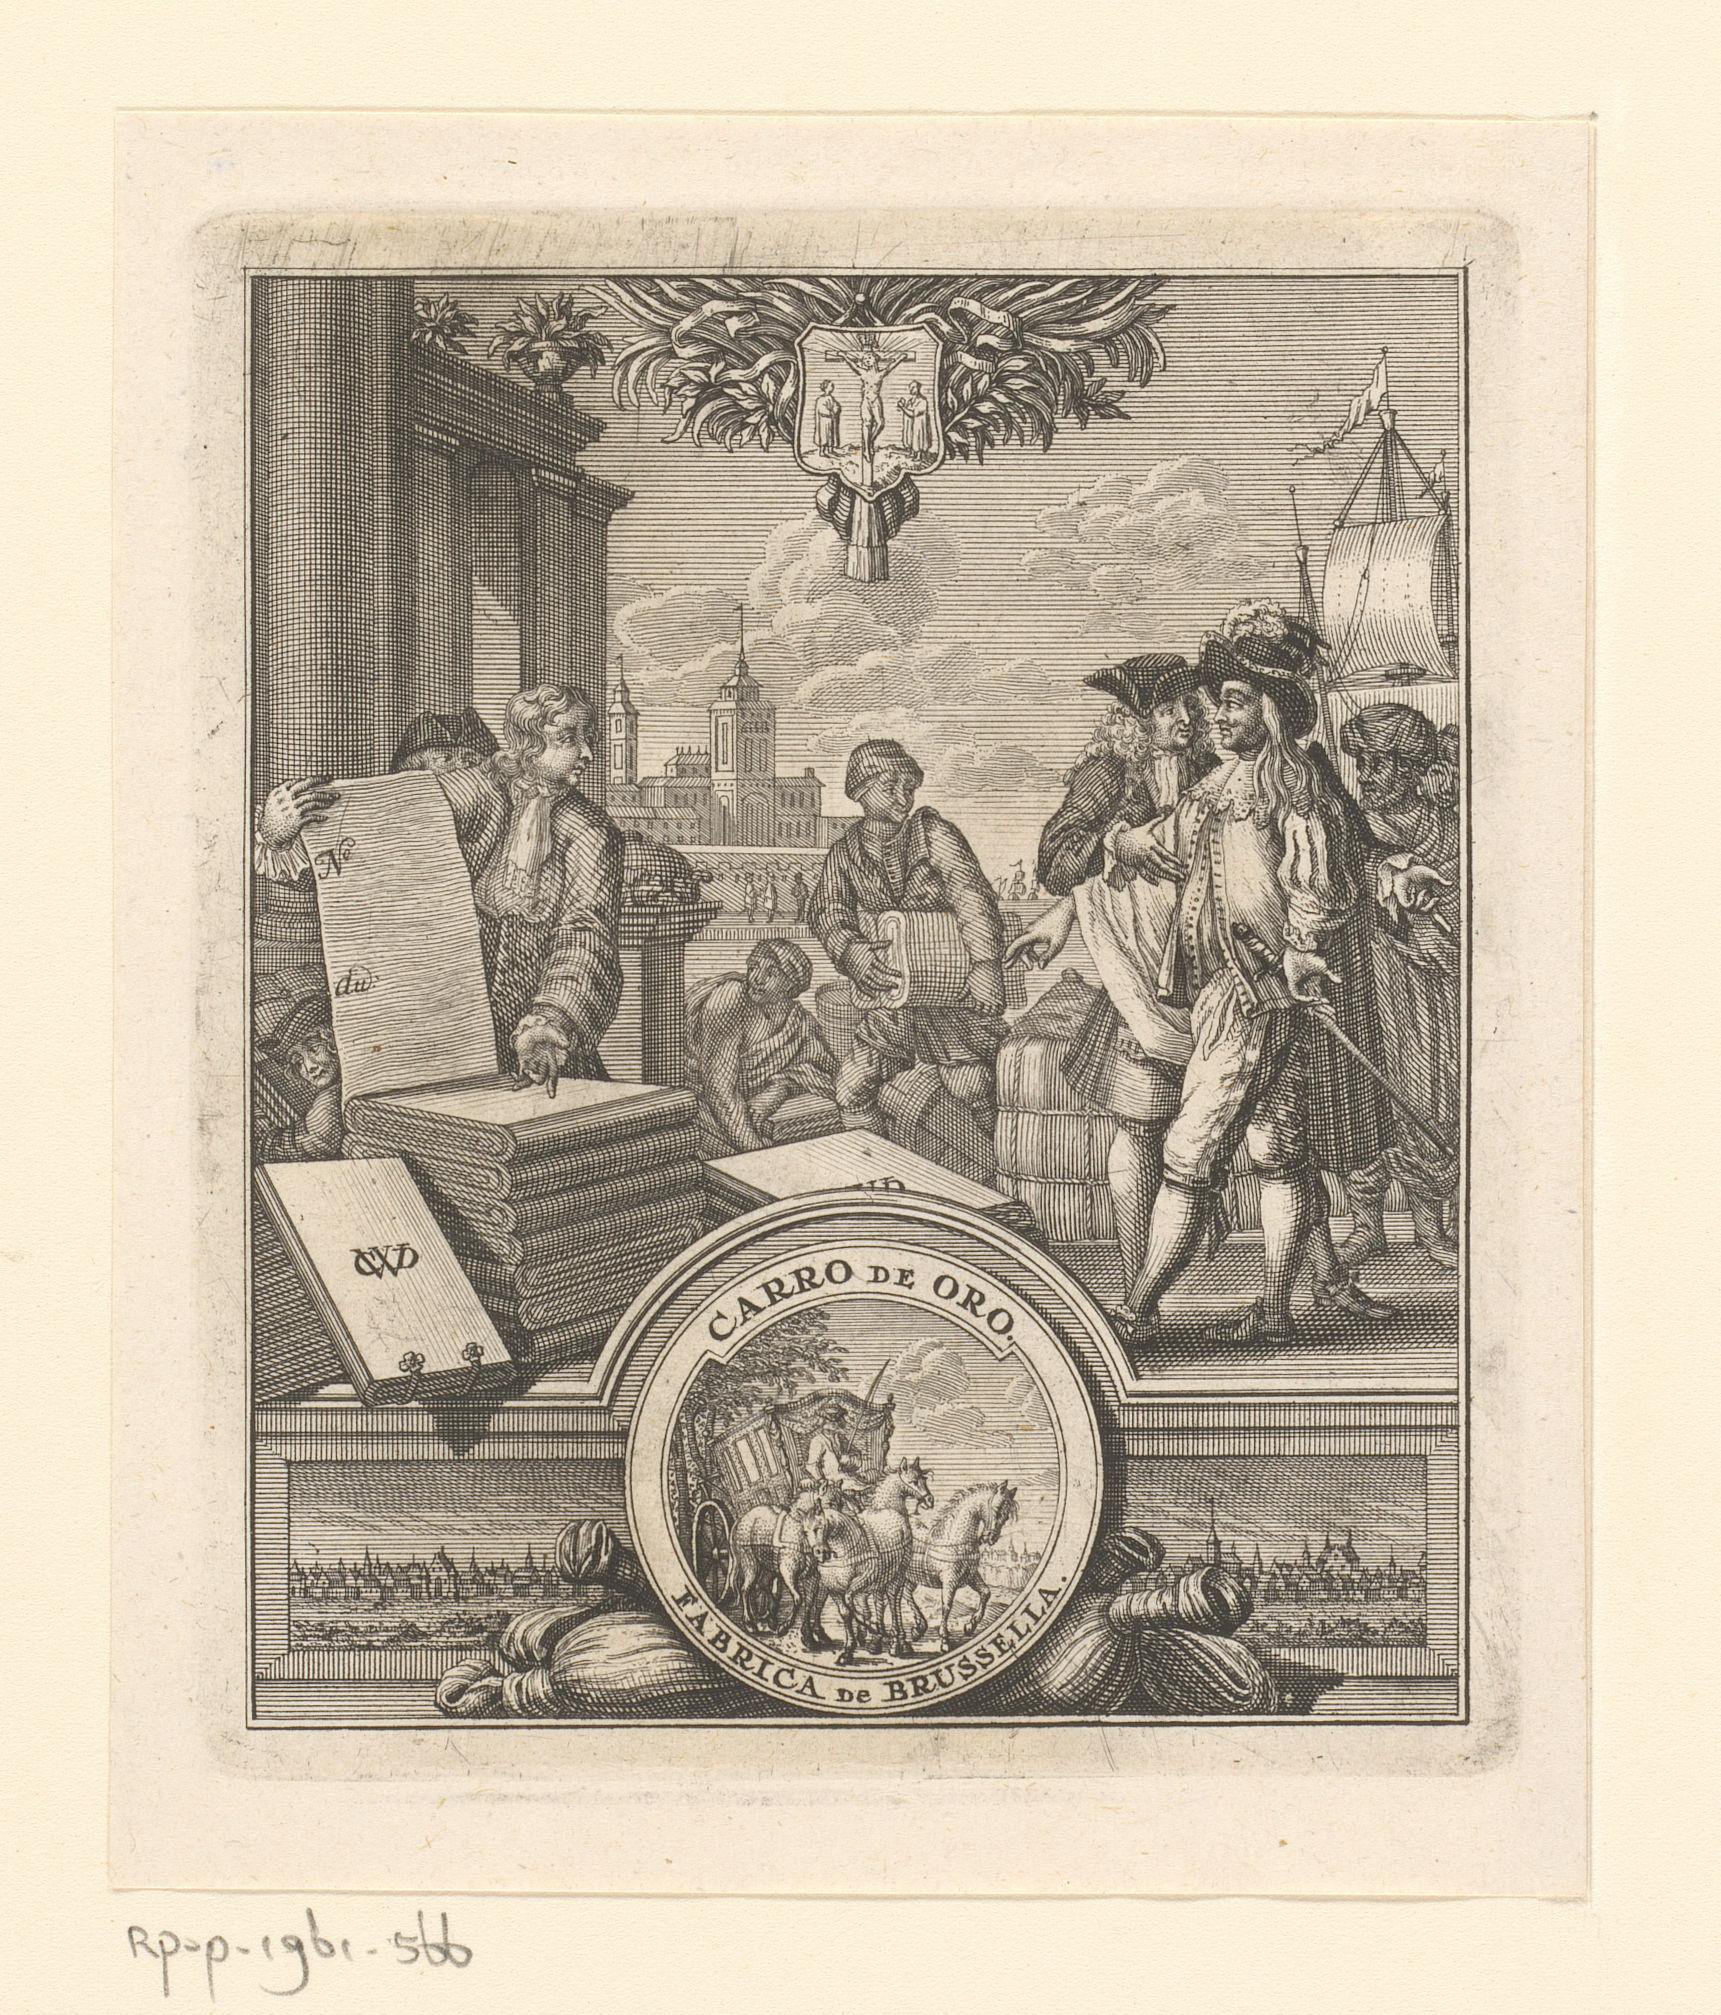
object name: print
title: Carro de Oro. Fabrica de Brussella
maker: Anonymous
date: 1700-1799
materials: paper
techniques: engraving, etching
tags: trade-company, materials ~ textile industry, textile fabric, cloth, brussels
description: Een man toont een stapel stoffen aan kooplieden. Op een van de stukken laken het monogram CWD. Midden boven een wapenschild met Christus aan het kruis. Onderaan een medaillon met een koets. Achter het medaillon een stadspanorama. Mogelijk de stad Brussel.